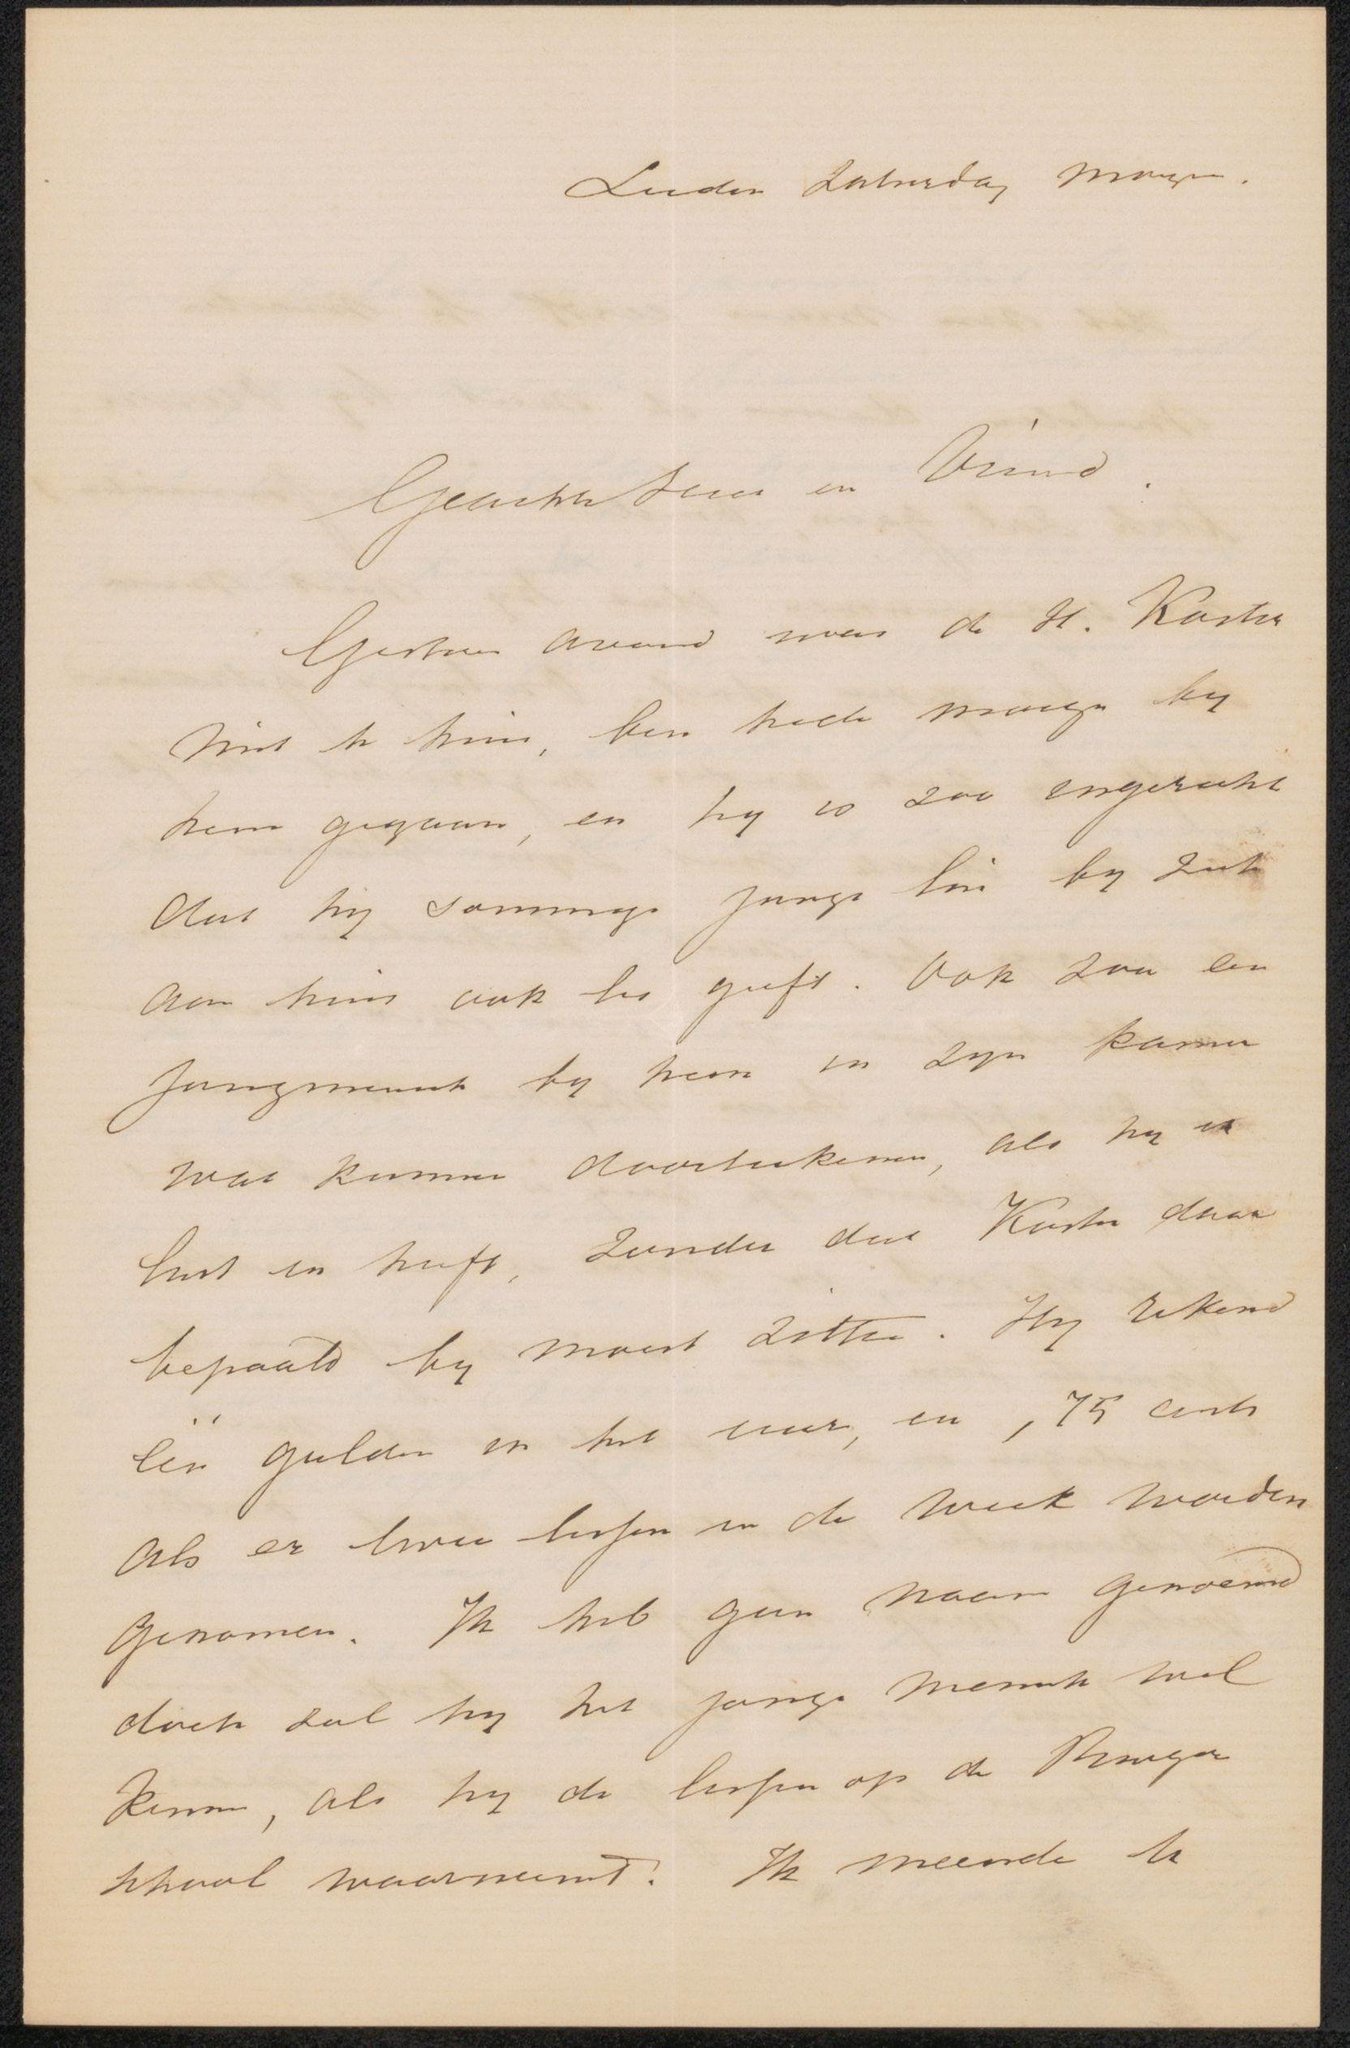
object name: letter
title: Brief aan August Allebé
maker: alexander hugo bakker korff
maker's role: draughtsman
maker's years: 1824-1882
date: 1848-1882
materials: ink, paper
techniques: pen, writing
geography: leiden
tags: amsterdam, print maker, august allebé, painter, johannes hubertus leonardus de haas, education, tuition of the artist (in general), money